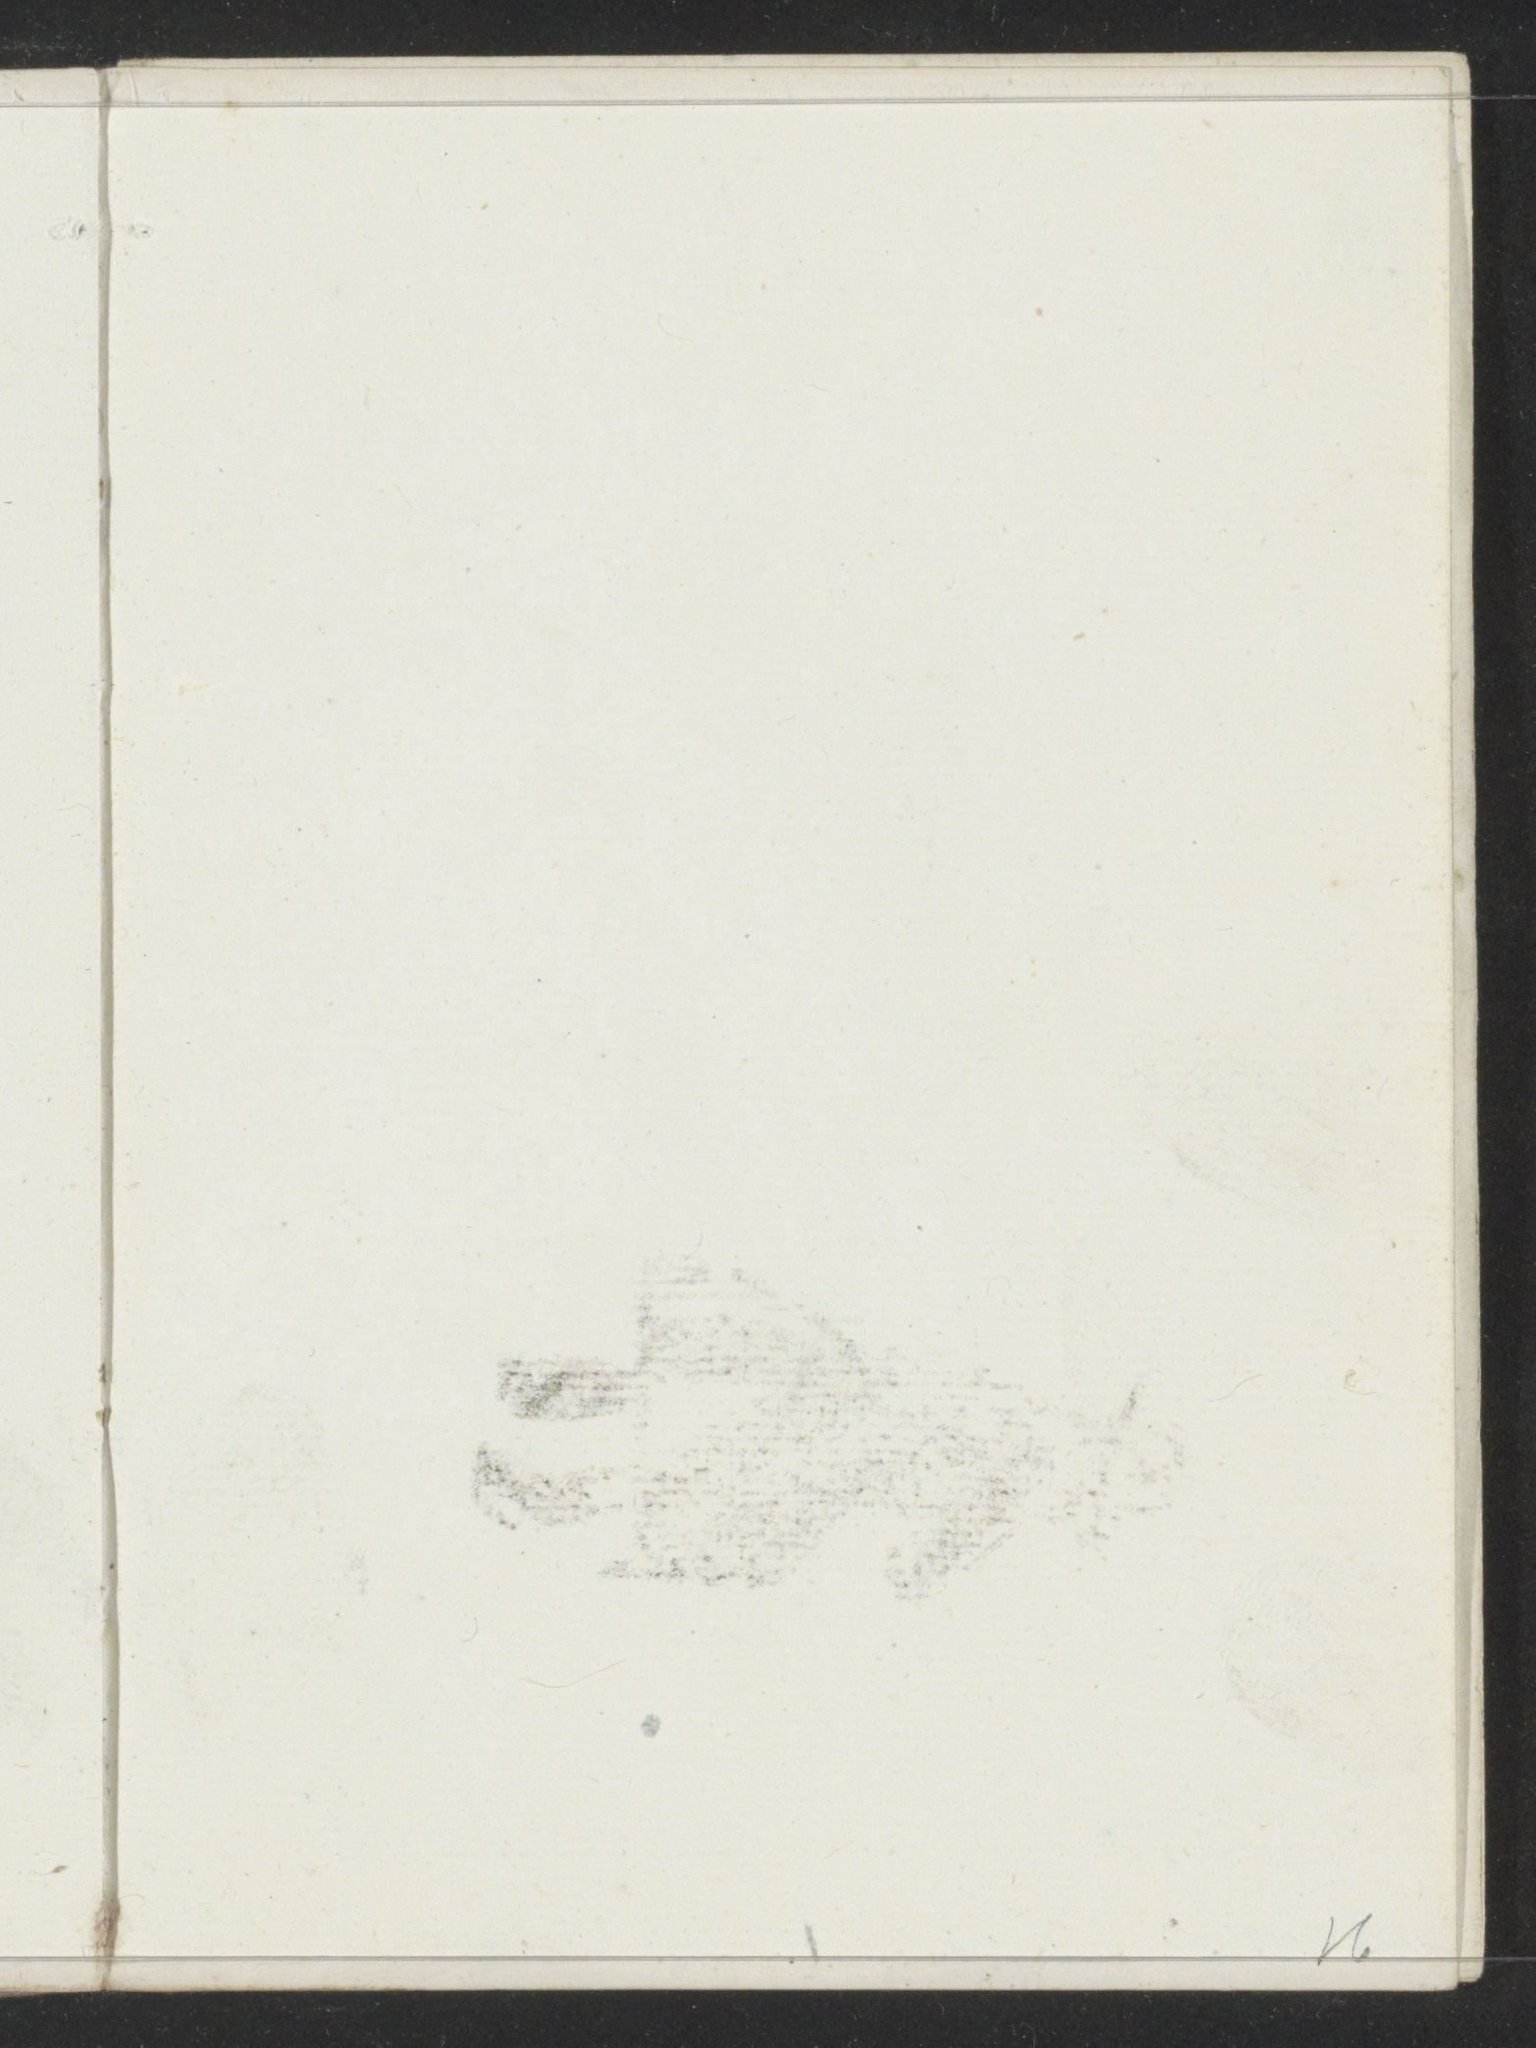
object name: sketchbook leaf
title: Abklatsch van de krijttekening op blad 15 verso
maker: isaac israels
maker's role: draughtsman, painter, print maker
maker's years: 1865-1934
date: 1886-1934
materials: paper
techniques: printmaking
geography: amsterdam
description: Blad 16 recto uit schetsboek LXIII met 23 bladen.